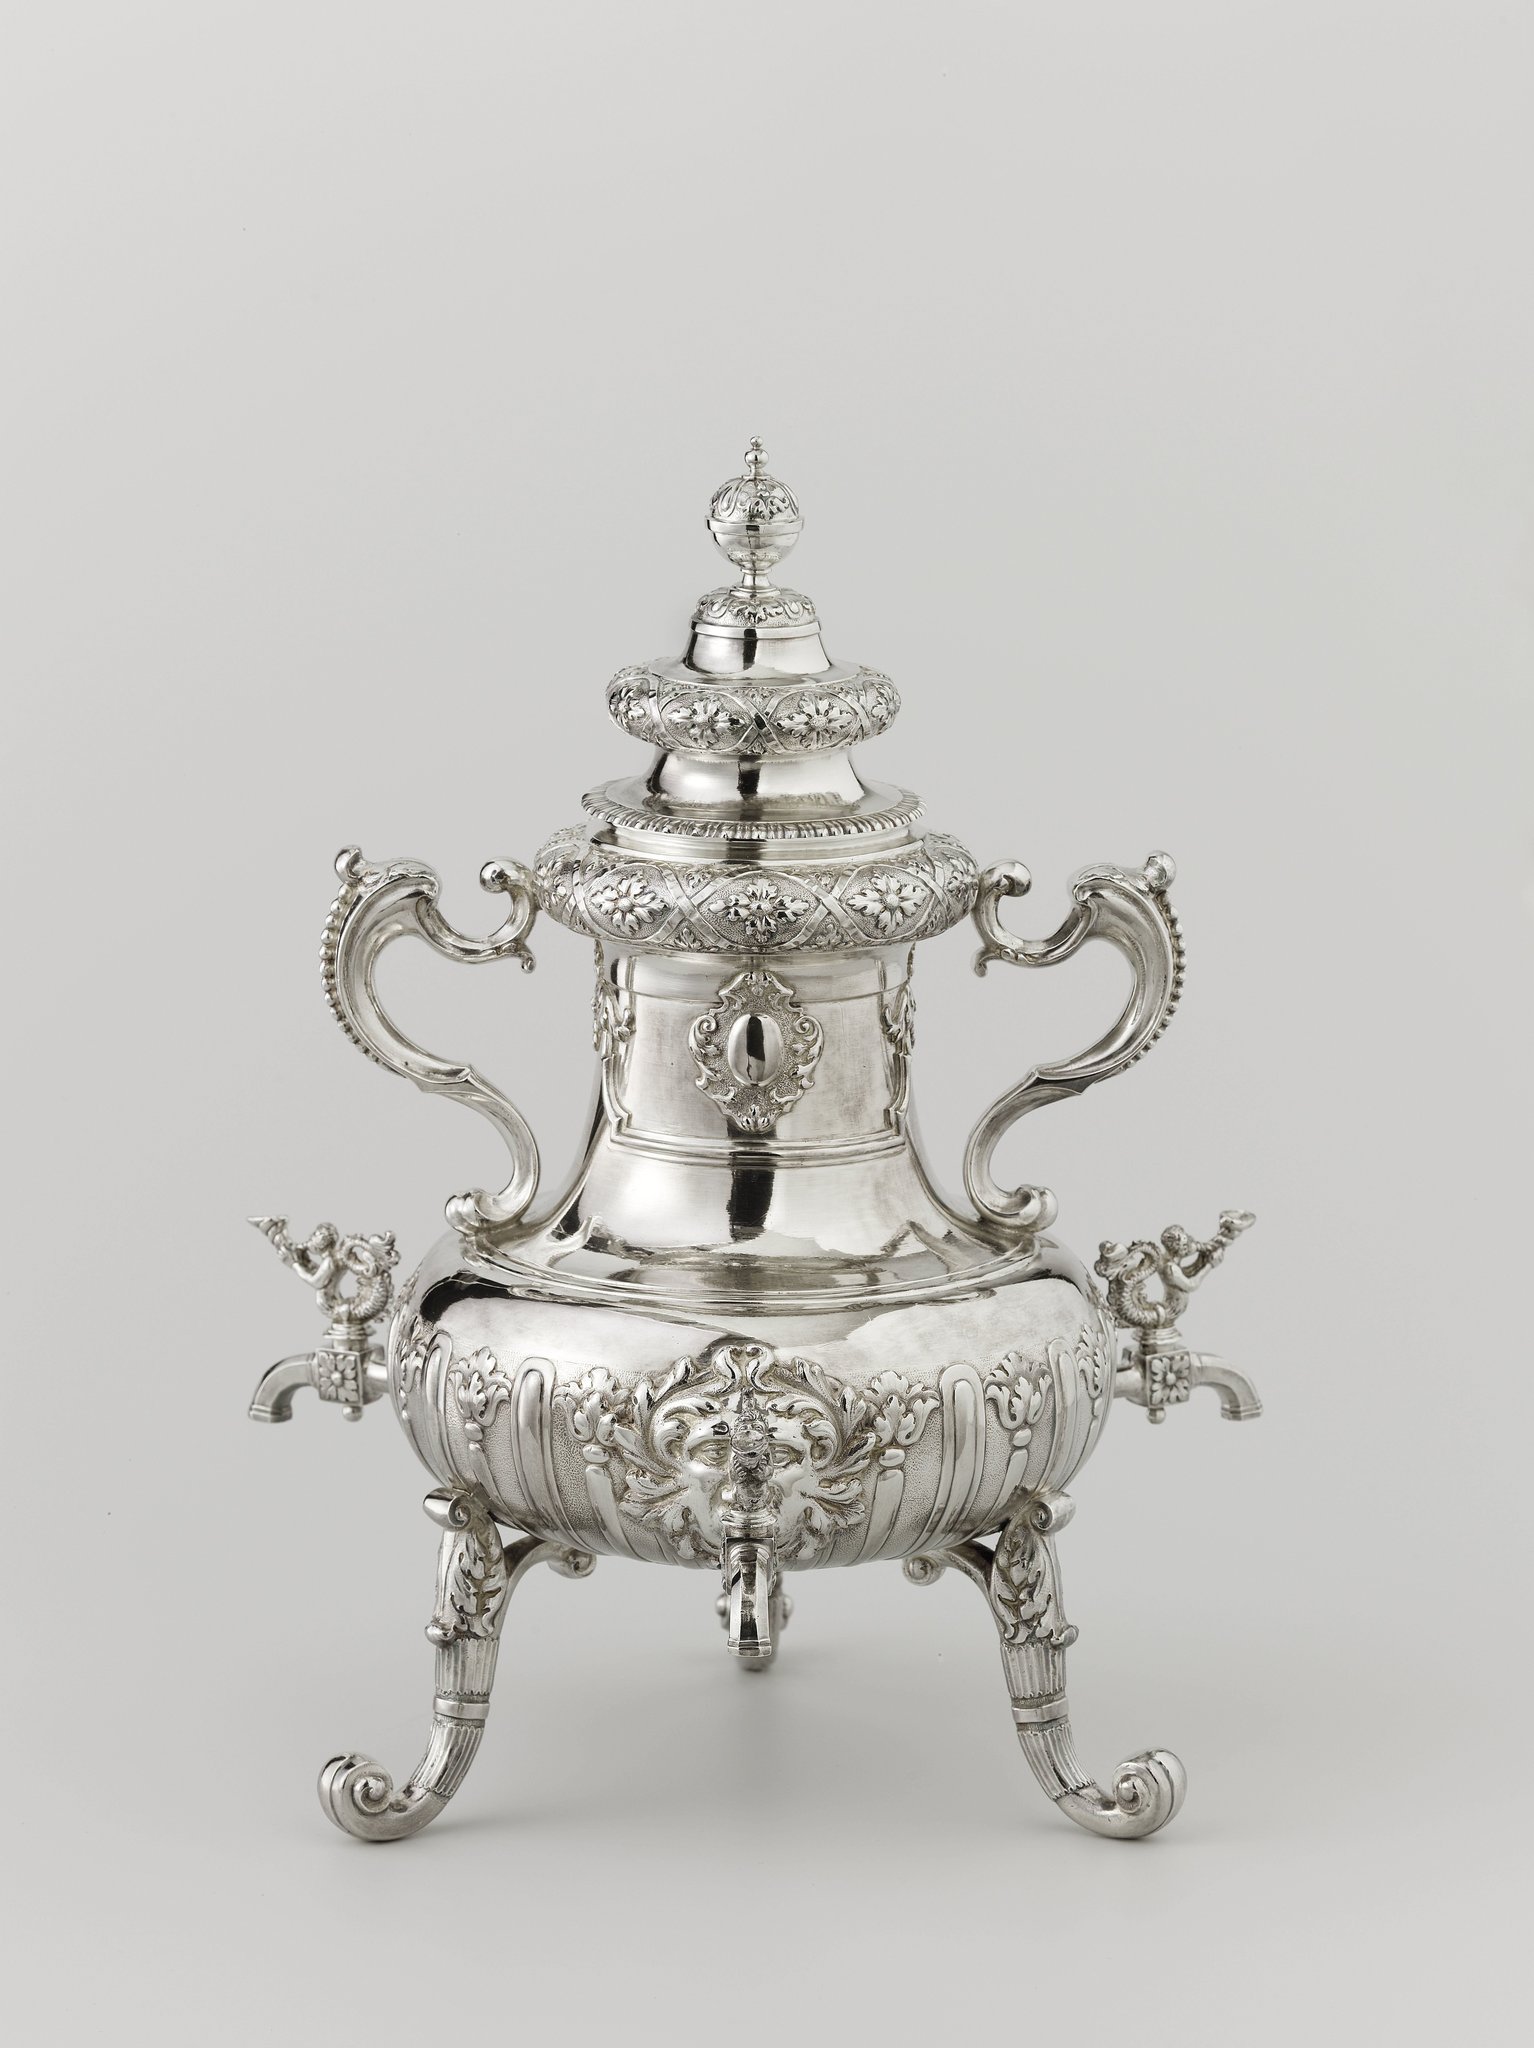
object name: coffee pot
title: Koffiekan, balustervormig, met drie kranen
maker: christiaan warenberg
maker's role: silversmith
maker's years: 1667-1747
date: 1717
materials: silver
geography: amsterdam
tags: mask, mascaron ~ ornament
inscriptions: town mark, alloy mark, maker's mark, : ‘T’, date letter: ‘G’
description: Coffee urn Silver Amsterdam, 1717, attributed to Christiaan Warenberg. Given by Miss M. Heineken, 1912.